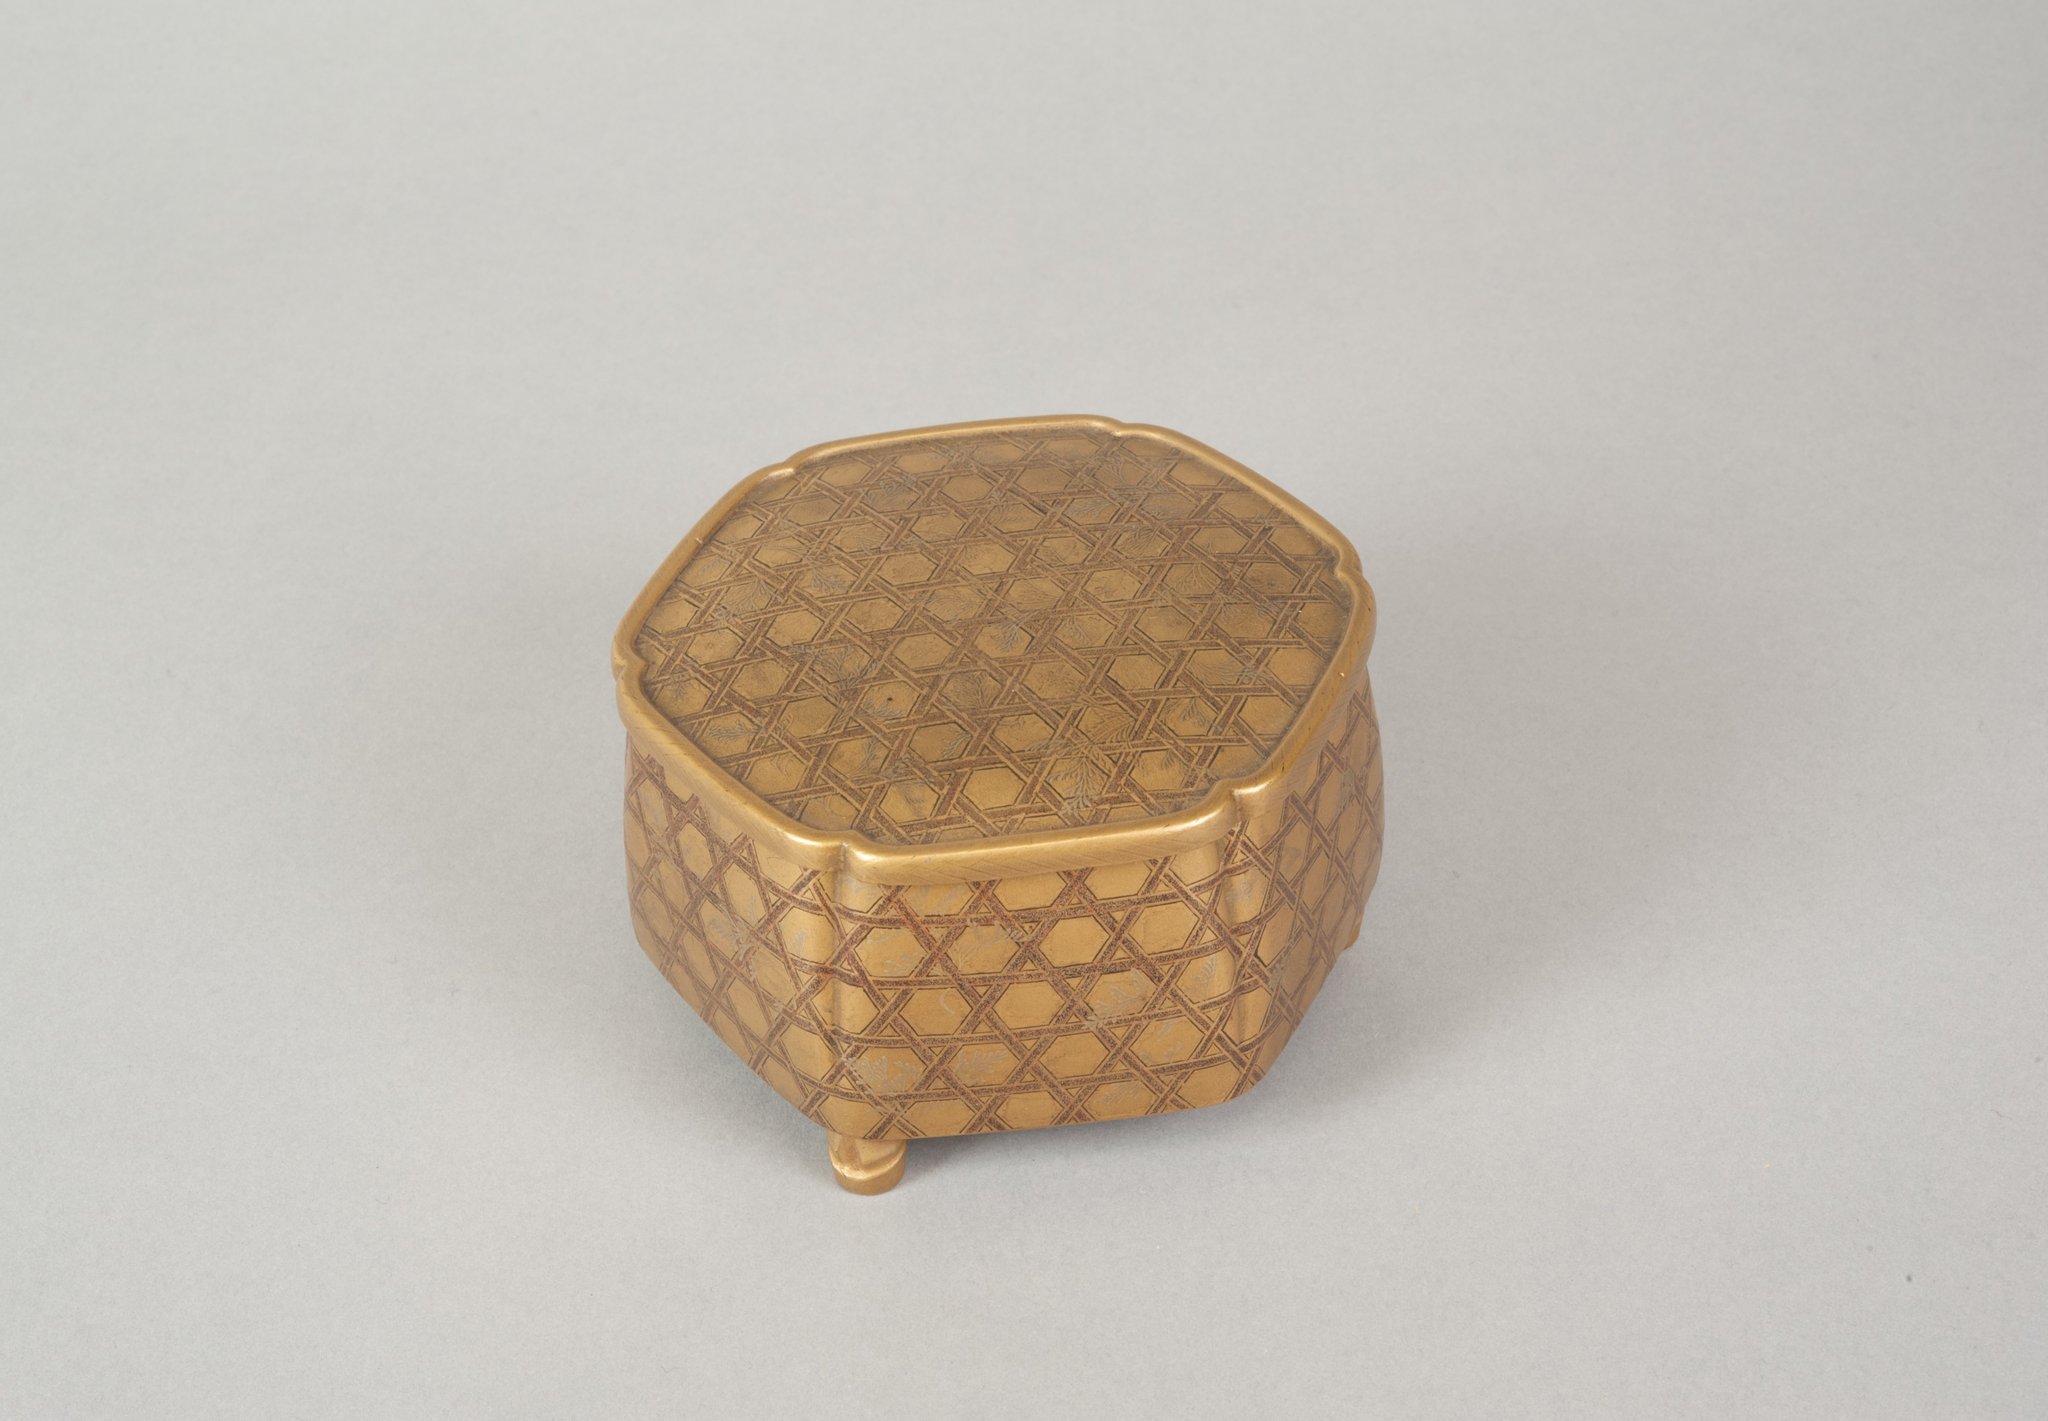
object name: cosmetic box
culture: japanese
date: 1867-1900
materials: lacquer